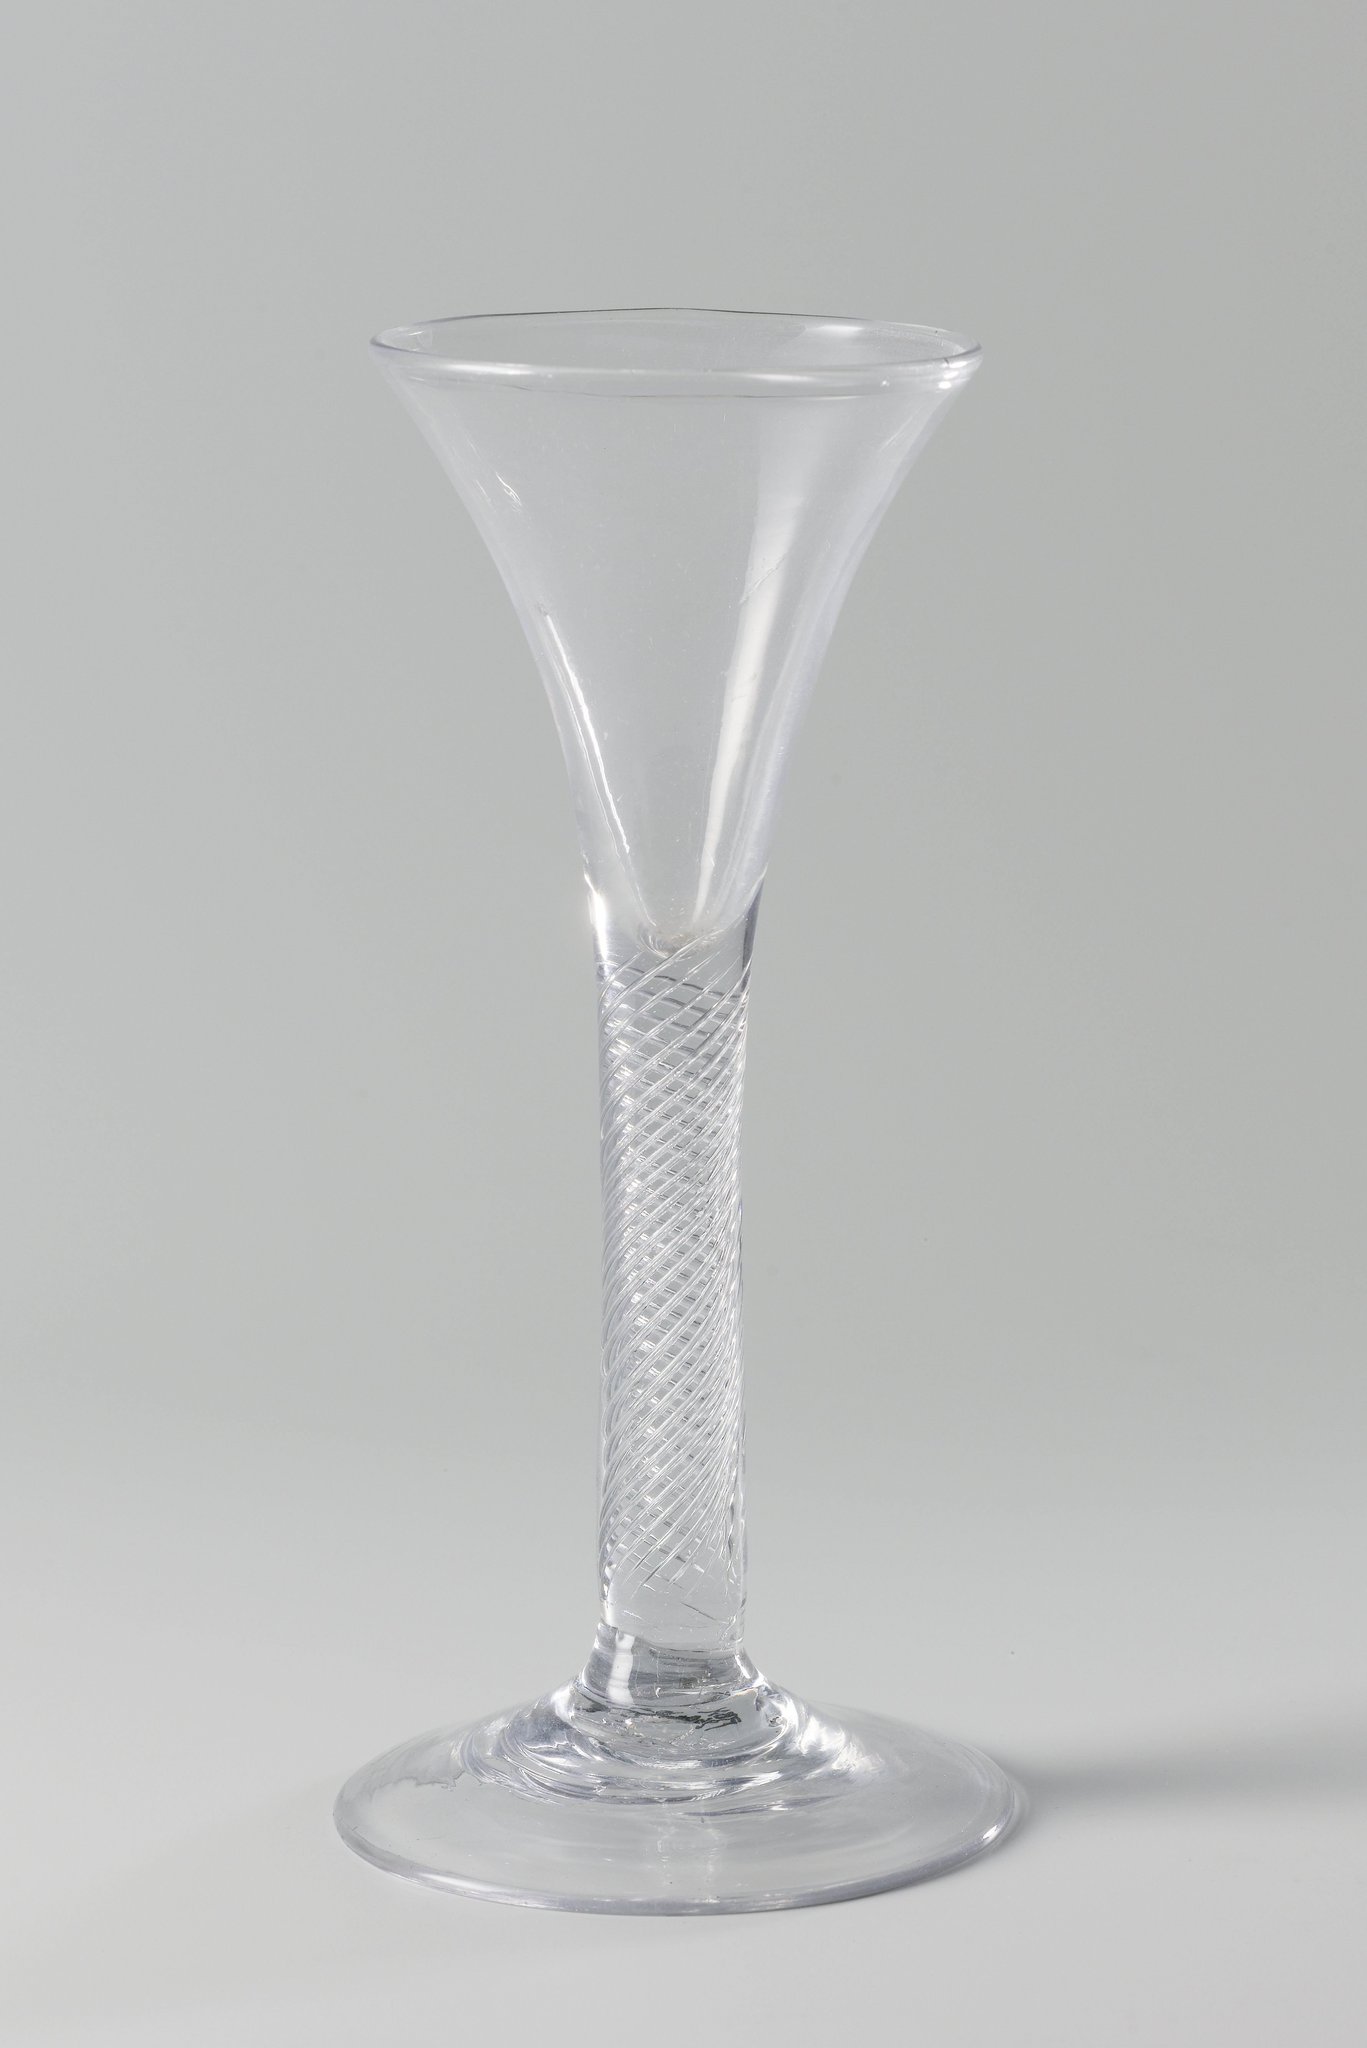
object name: goblet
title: Slingerglas met trompetvormige kelk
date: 1750-1775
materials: glass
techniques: glassblowing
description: Slingerglas met conische voet en licht uitlopende stam. In de stam meervoudige luchtspiraal. Stam doorlopend in trompetvormige kelk.